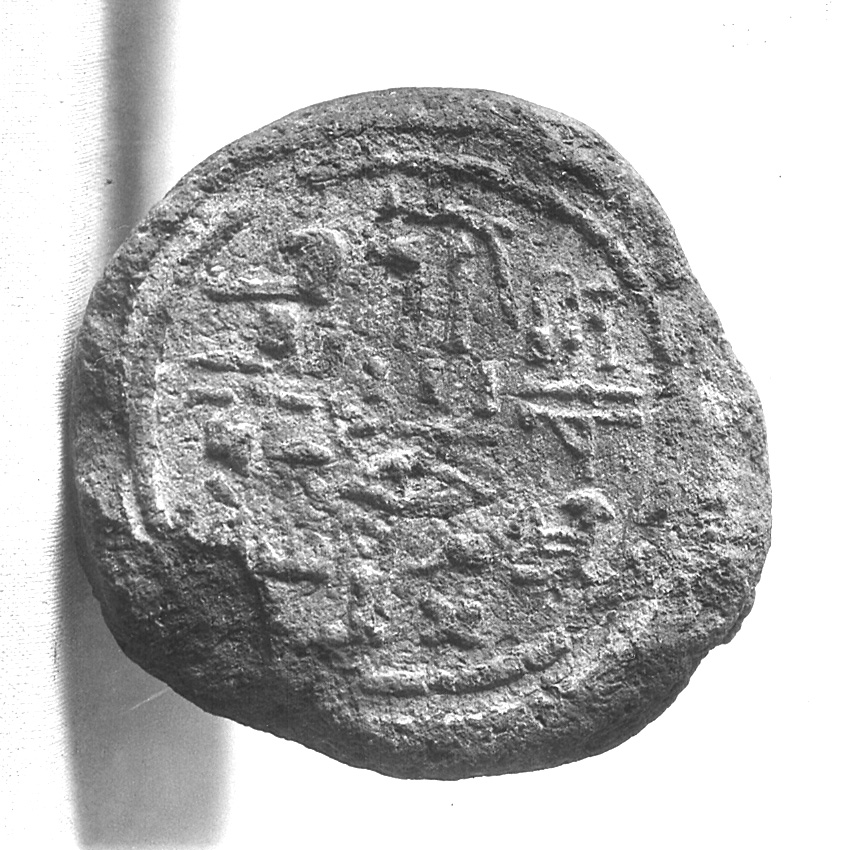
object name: cone, circular impression, min, scribe, overseer, priest, osiris, oasis, tt 109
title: Funerary Cone of the Scribe Min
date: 1479-1425 BCE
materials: pottery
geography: egypt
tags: hieroglyphs